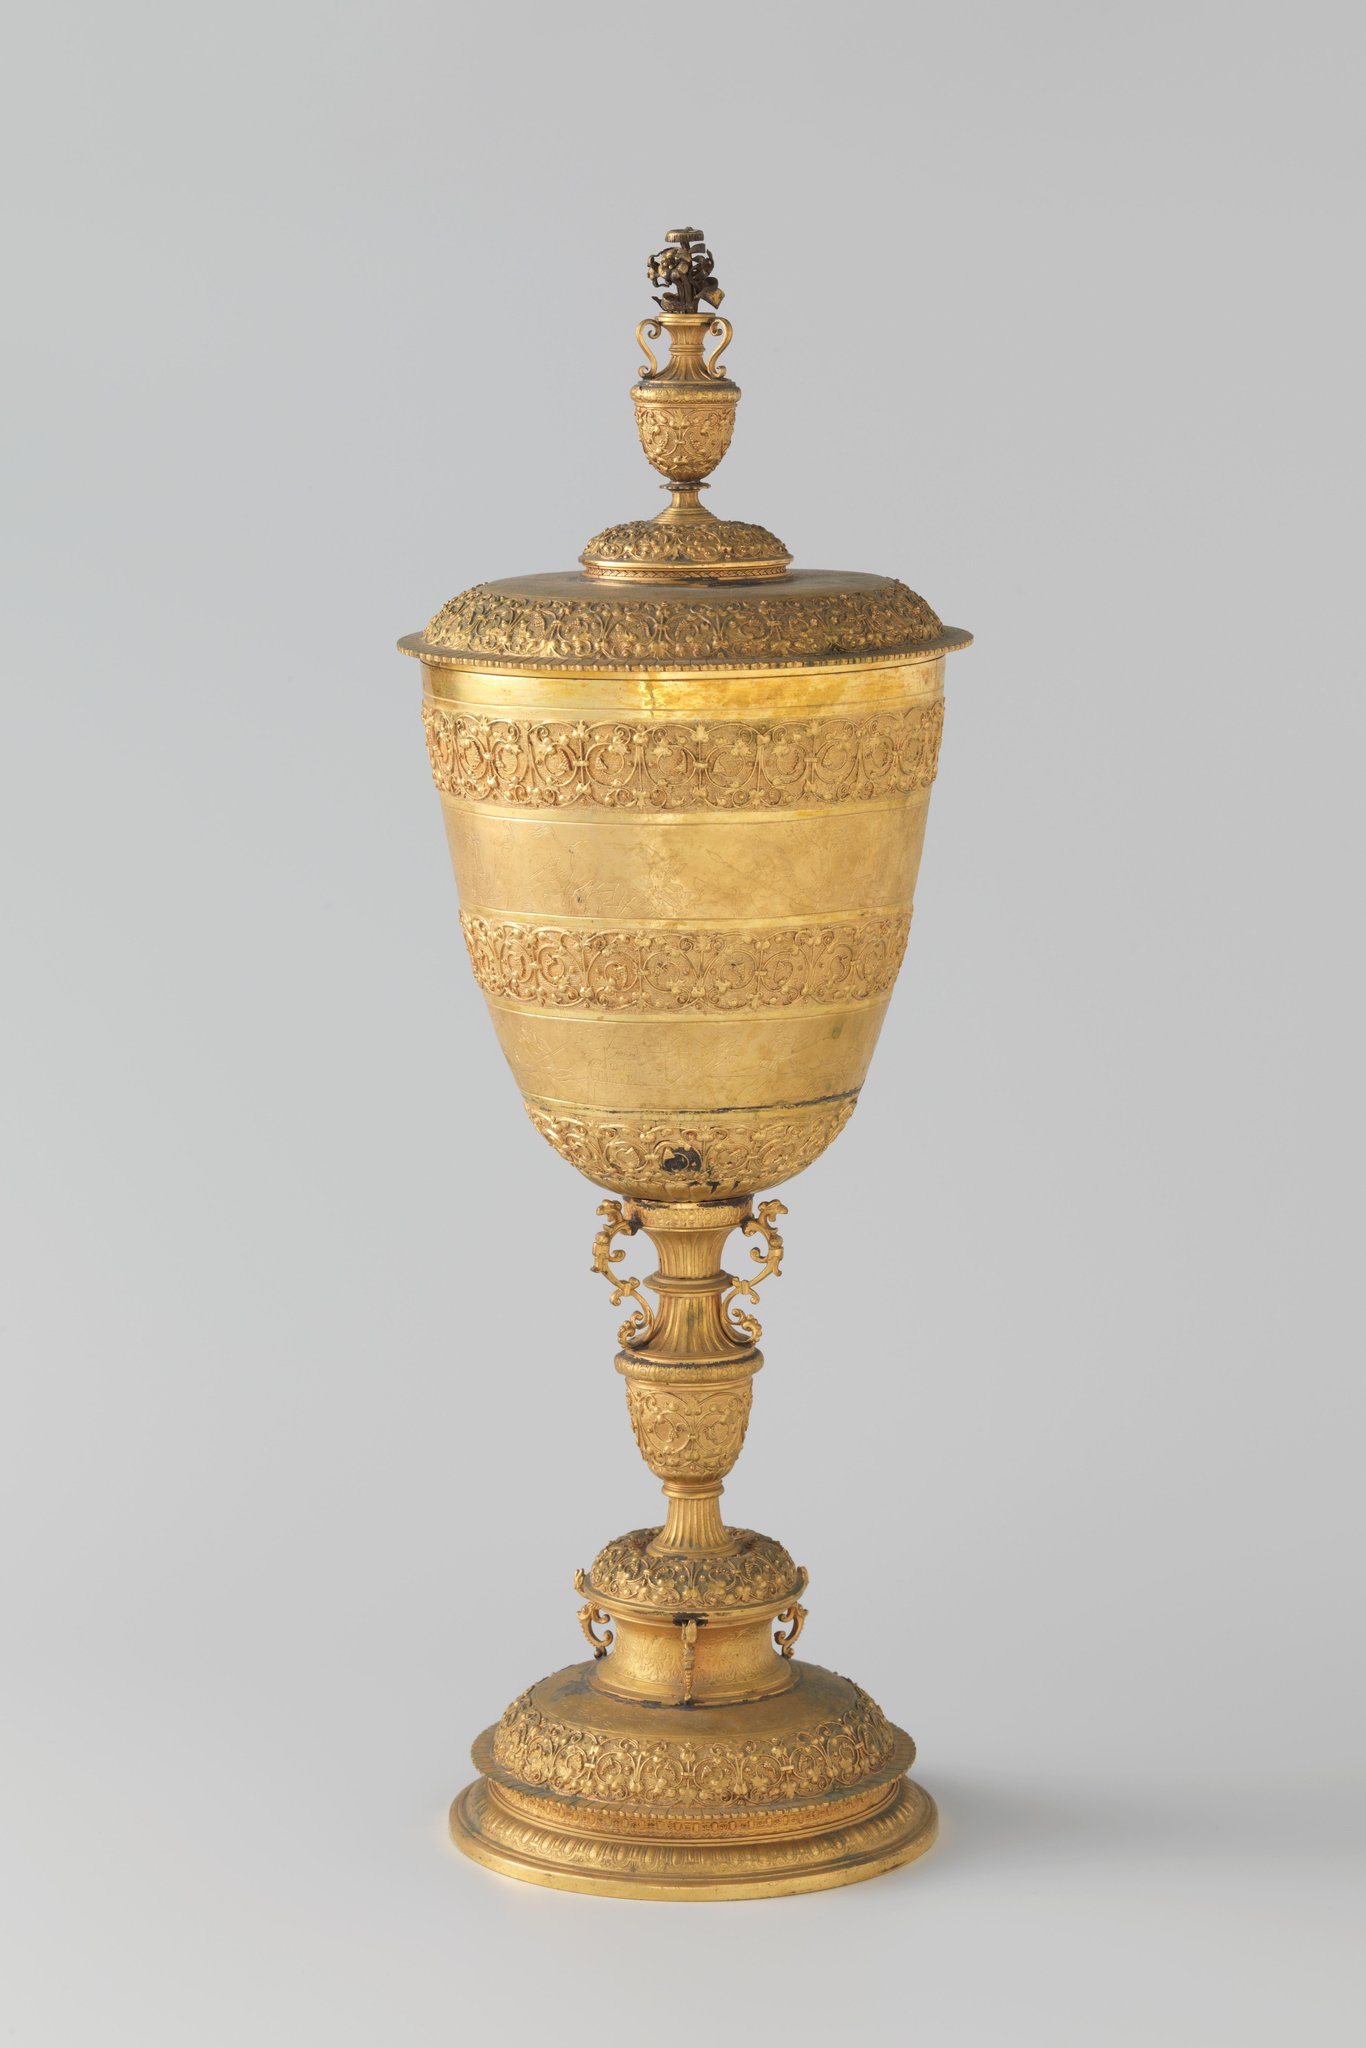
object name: goblet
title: Galvanoplastische reproductie van een bokaal met deksel met scènes gerelateerd aan de jacht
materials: copper, silver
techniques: gilding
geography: london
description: Galvanoplastische reproductie van een bokaal met deksel, met banden met gegraveerde scènes met onderwerpen gerelateerd aan de jacht afgewisseld met banden met rolwerk in relief; een vaas met bloemen vormt de bekroning van het deksel.